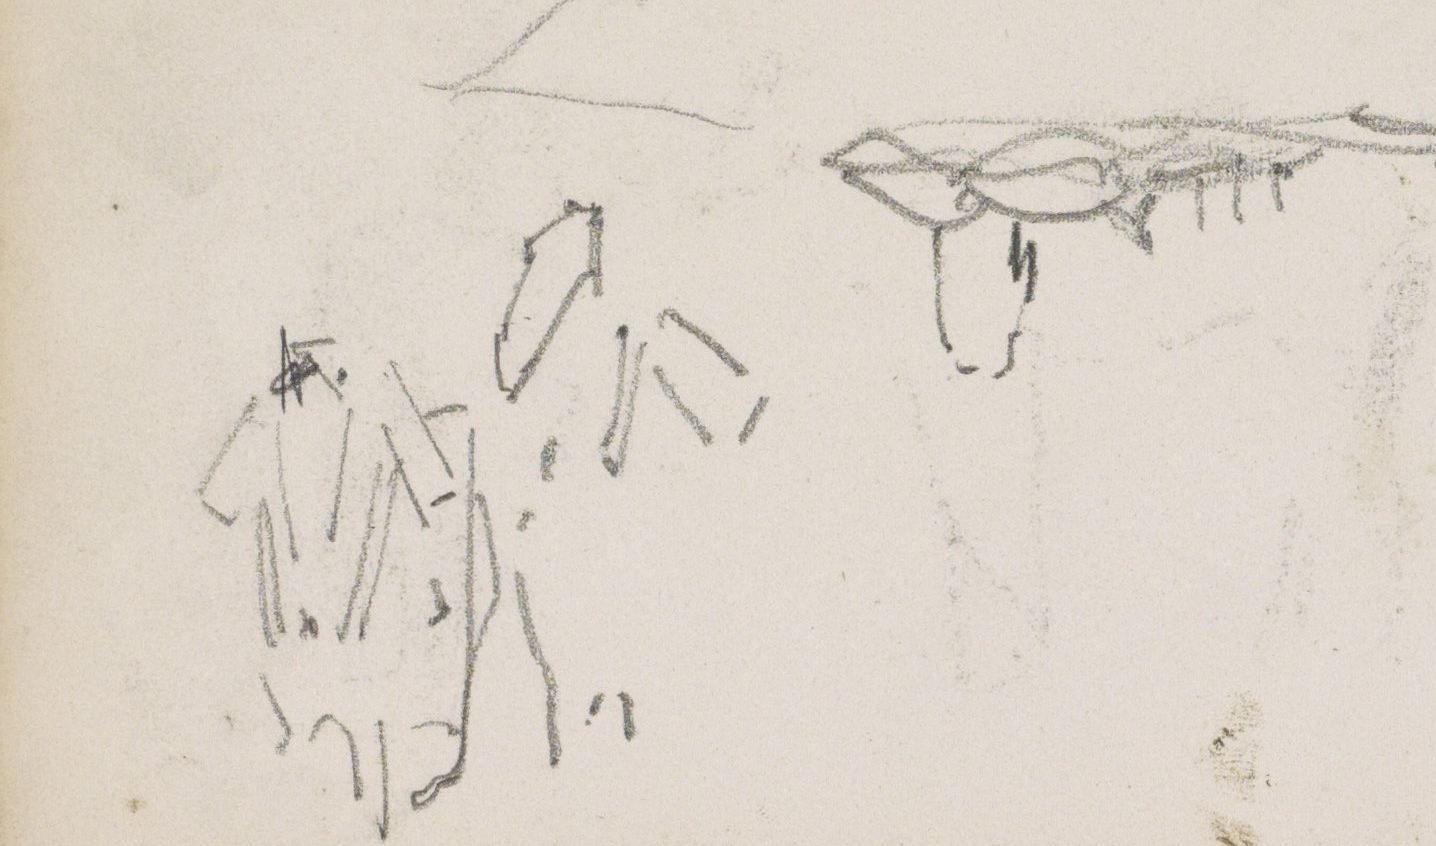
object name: sketchbook leaf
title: Studieblad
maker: george hendrik breitner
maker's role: draughtsman, painter, print maker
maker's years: 1857-1923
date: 1881-1883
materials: paper, pencil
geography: north brabant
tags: landscapes, windmill in landscape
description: Mogelijk onder andere een landschap met molen. Pagina 51 uit een schetsboek met 42 bladen.